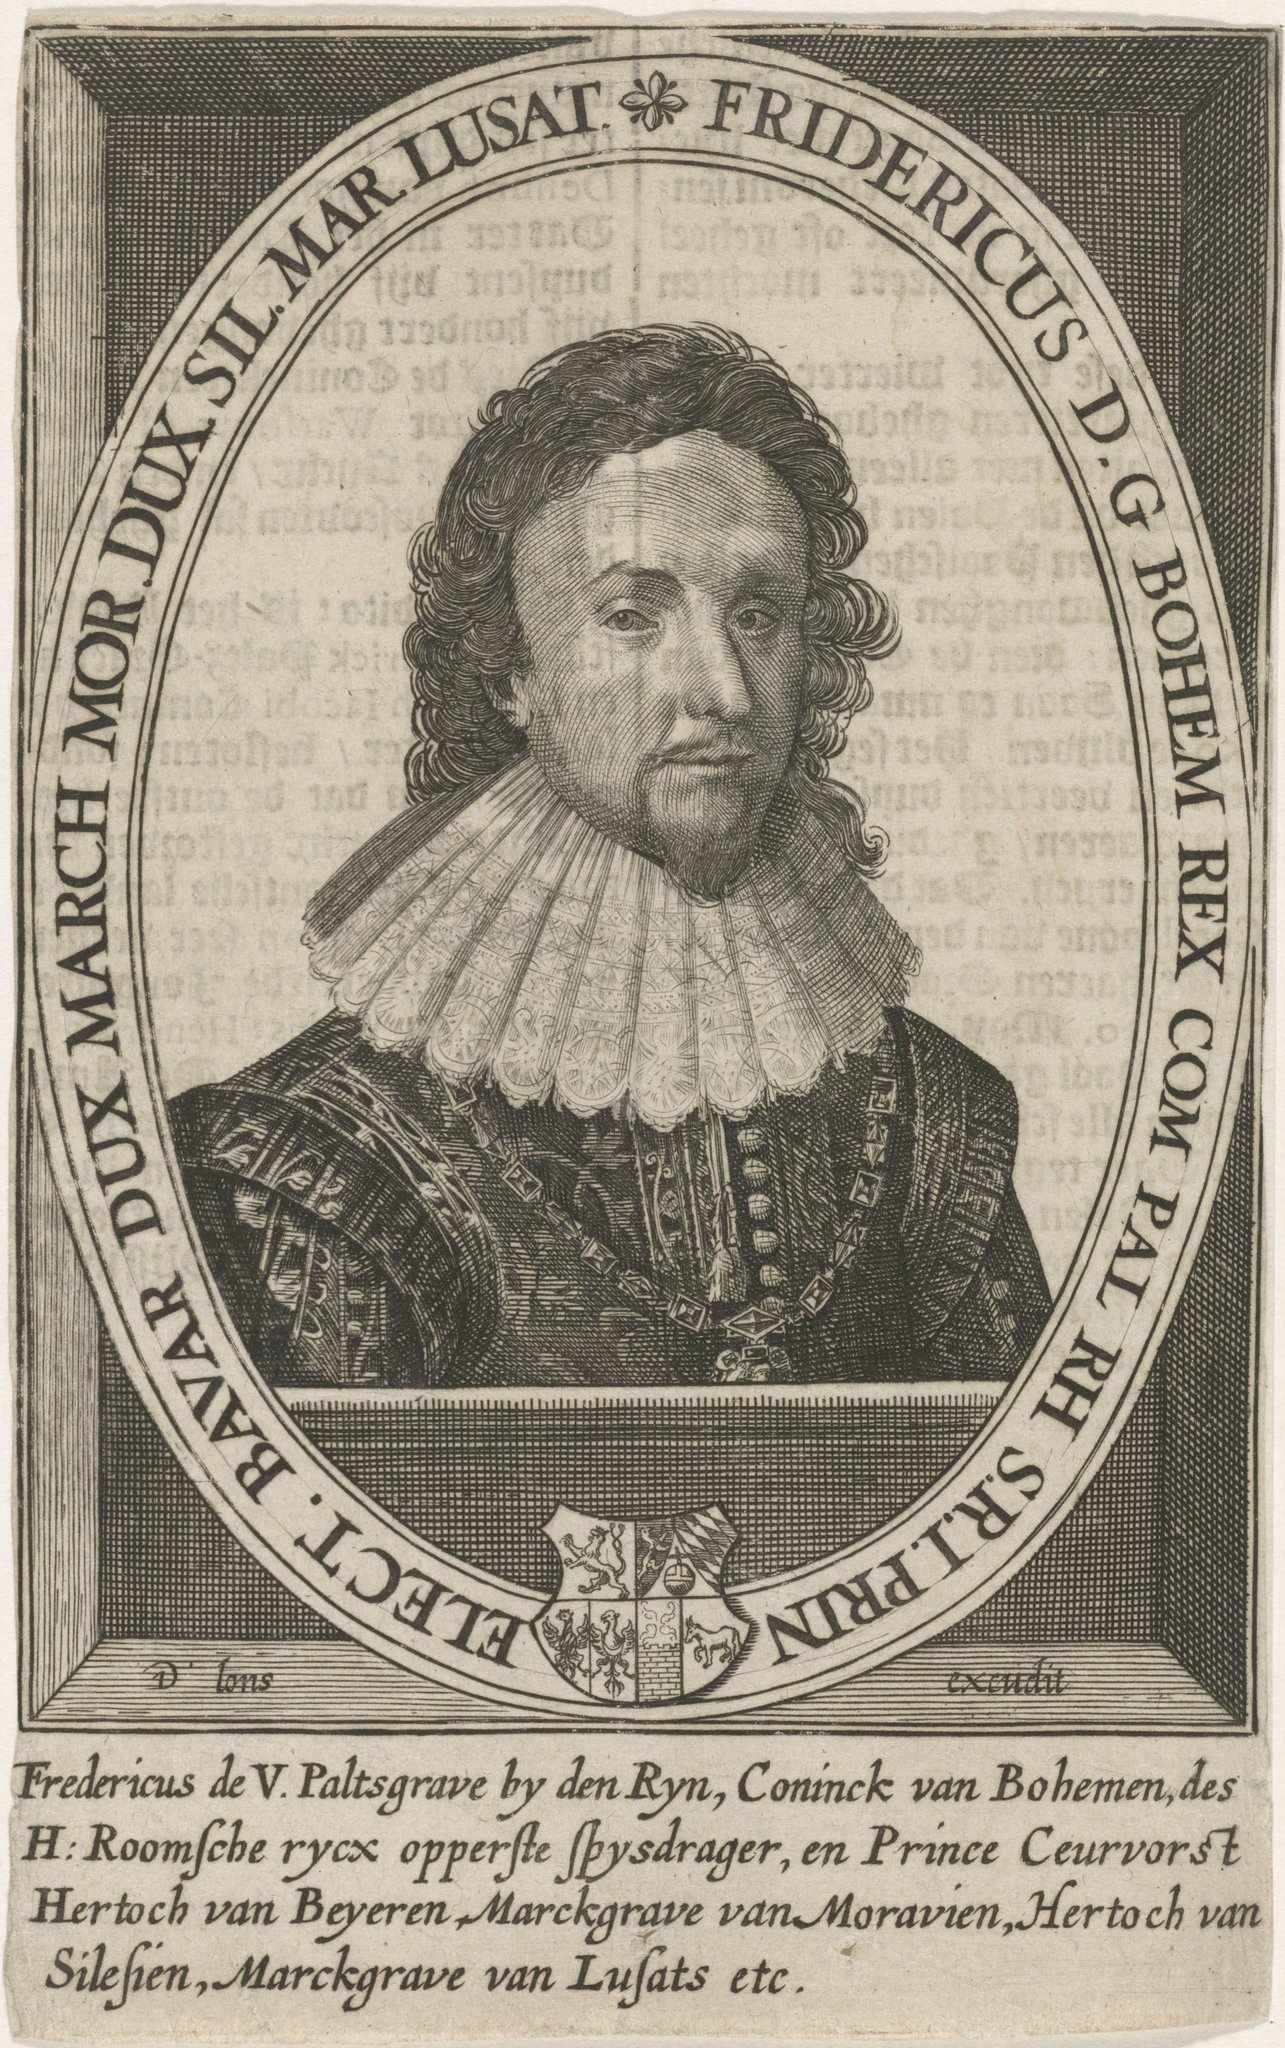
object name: book illustration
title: Portret van Frederik V van de Palts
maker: dirk eversen lons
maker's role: print maker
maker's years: 1599-1686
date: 1609-1686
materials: paper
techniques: engraving, letterpress printing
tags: amberg, frederik v (keurvorst van de palts, koning van bohemen)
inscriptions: collector's mark: Lugt 2228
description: Portret van Frederik V, keurvorst van de Palts, koning van Bohemen. Met familiewapen en een vierregelig onderschrift.